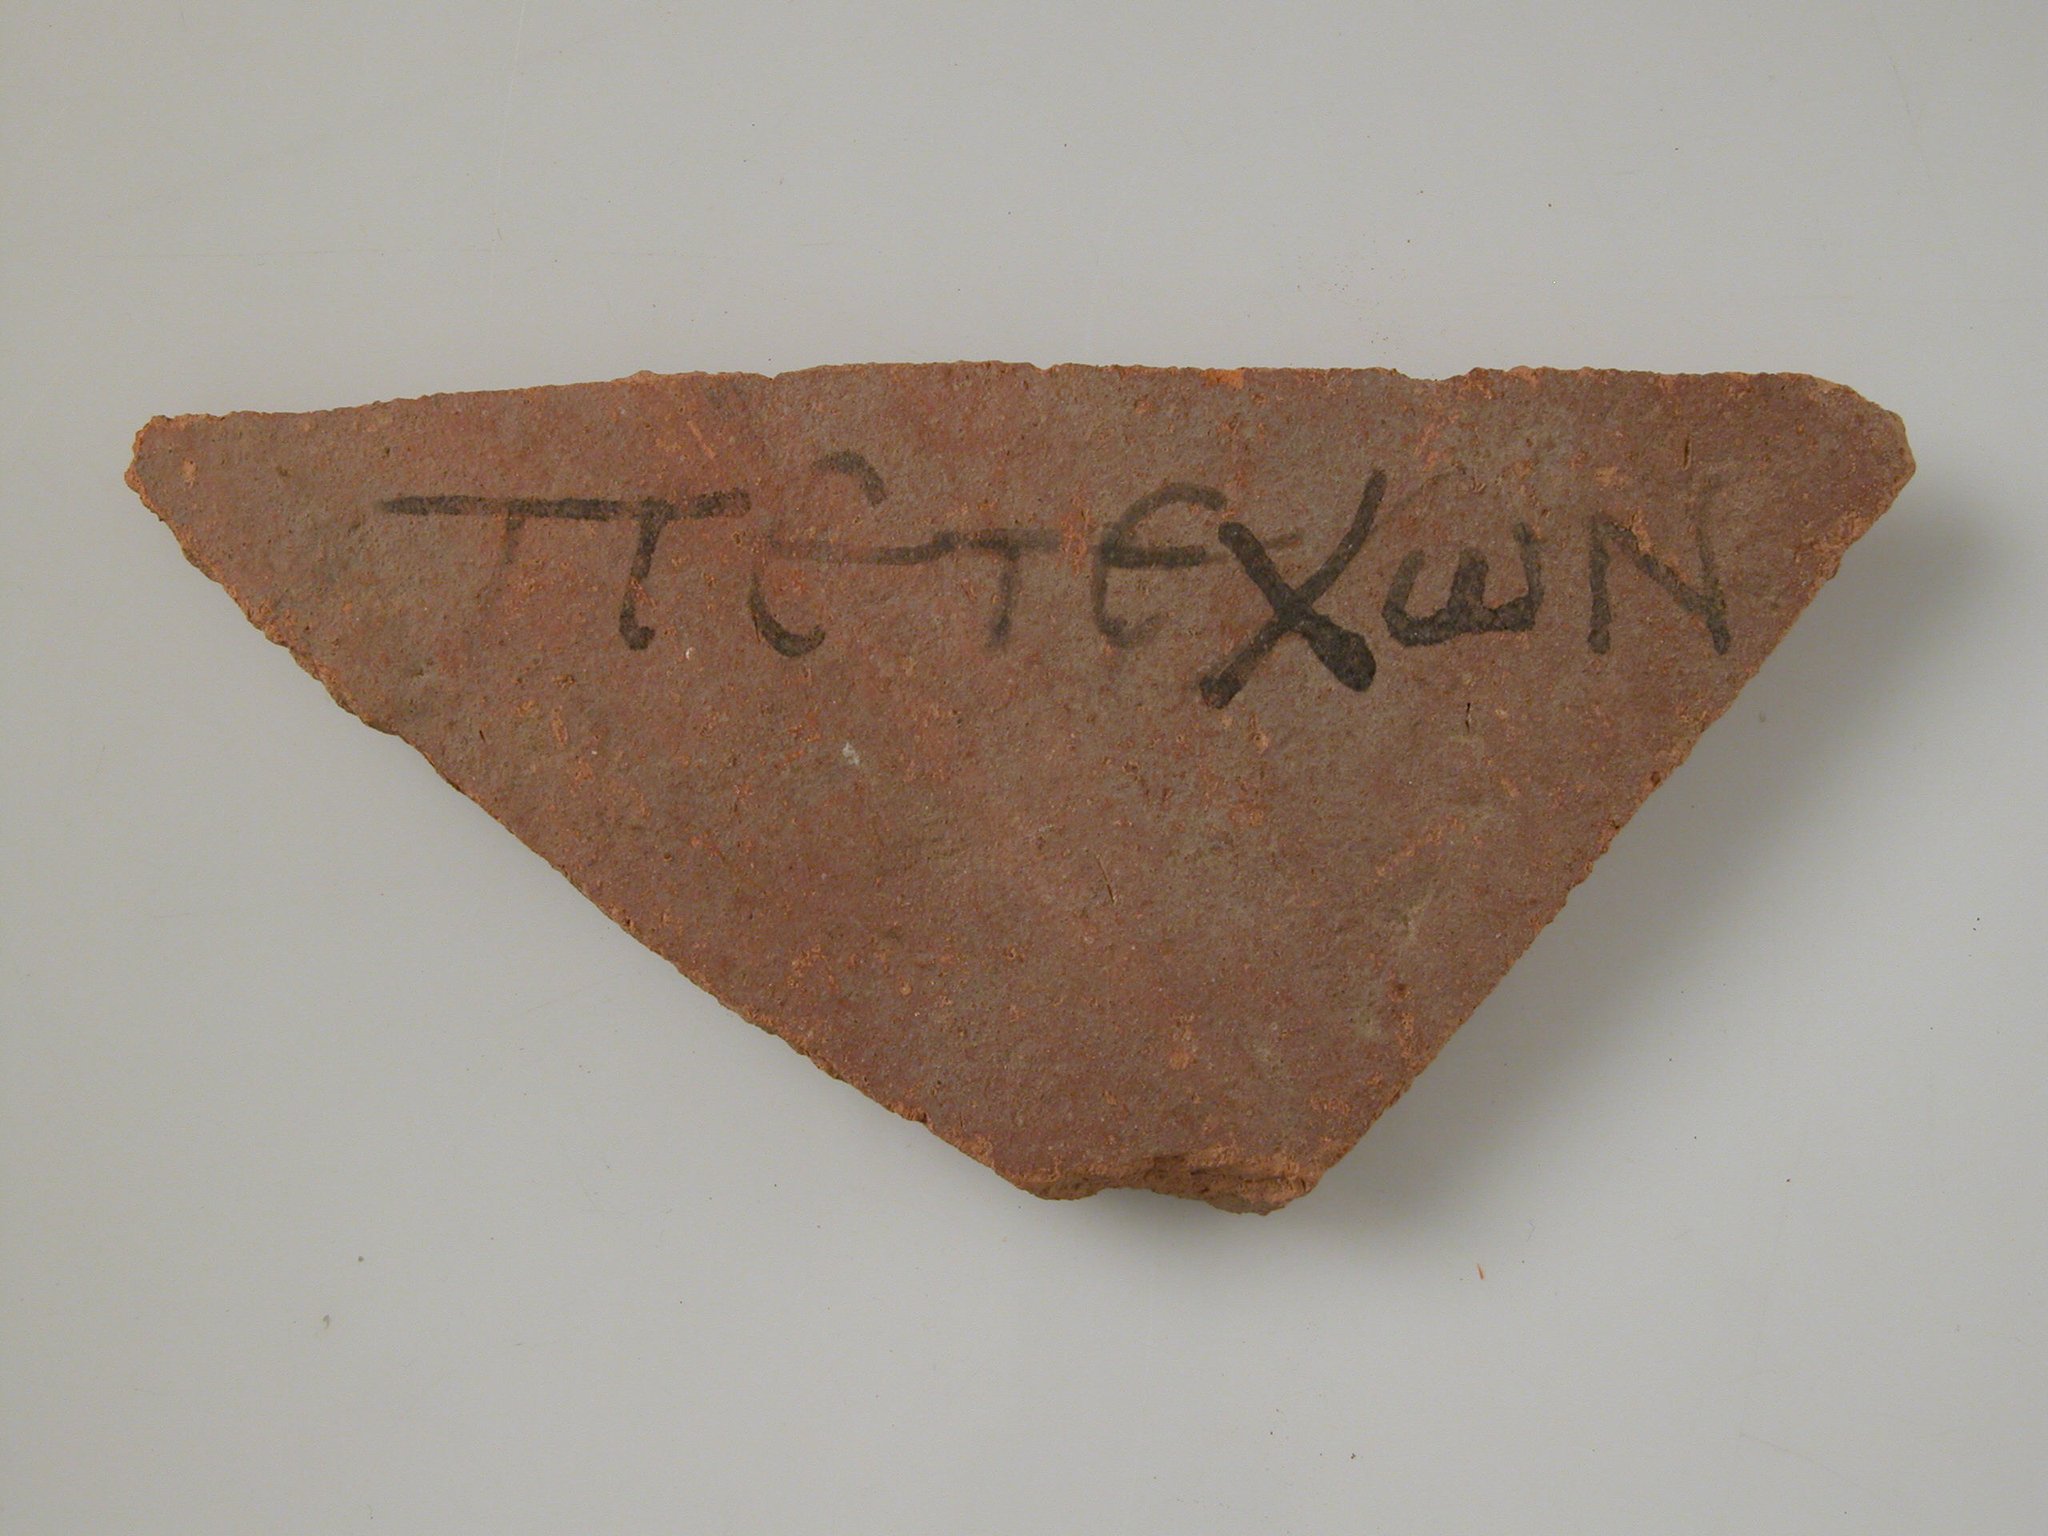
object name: ostrakon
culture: coptic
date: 301-700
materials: ink, pottery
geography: egypt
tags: documents